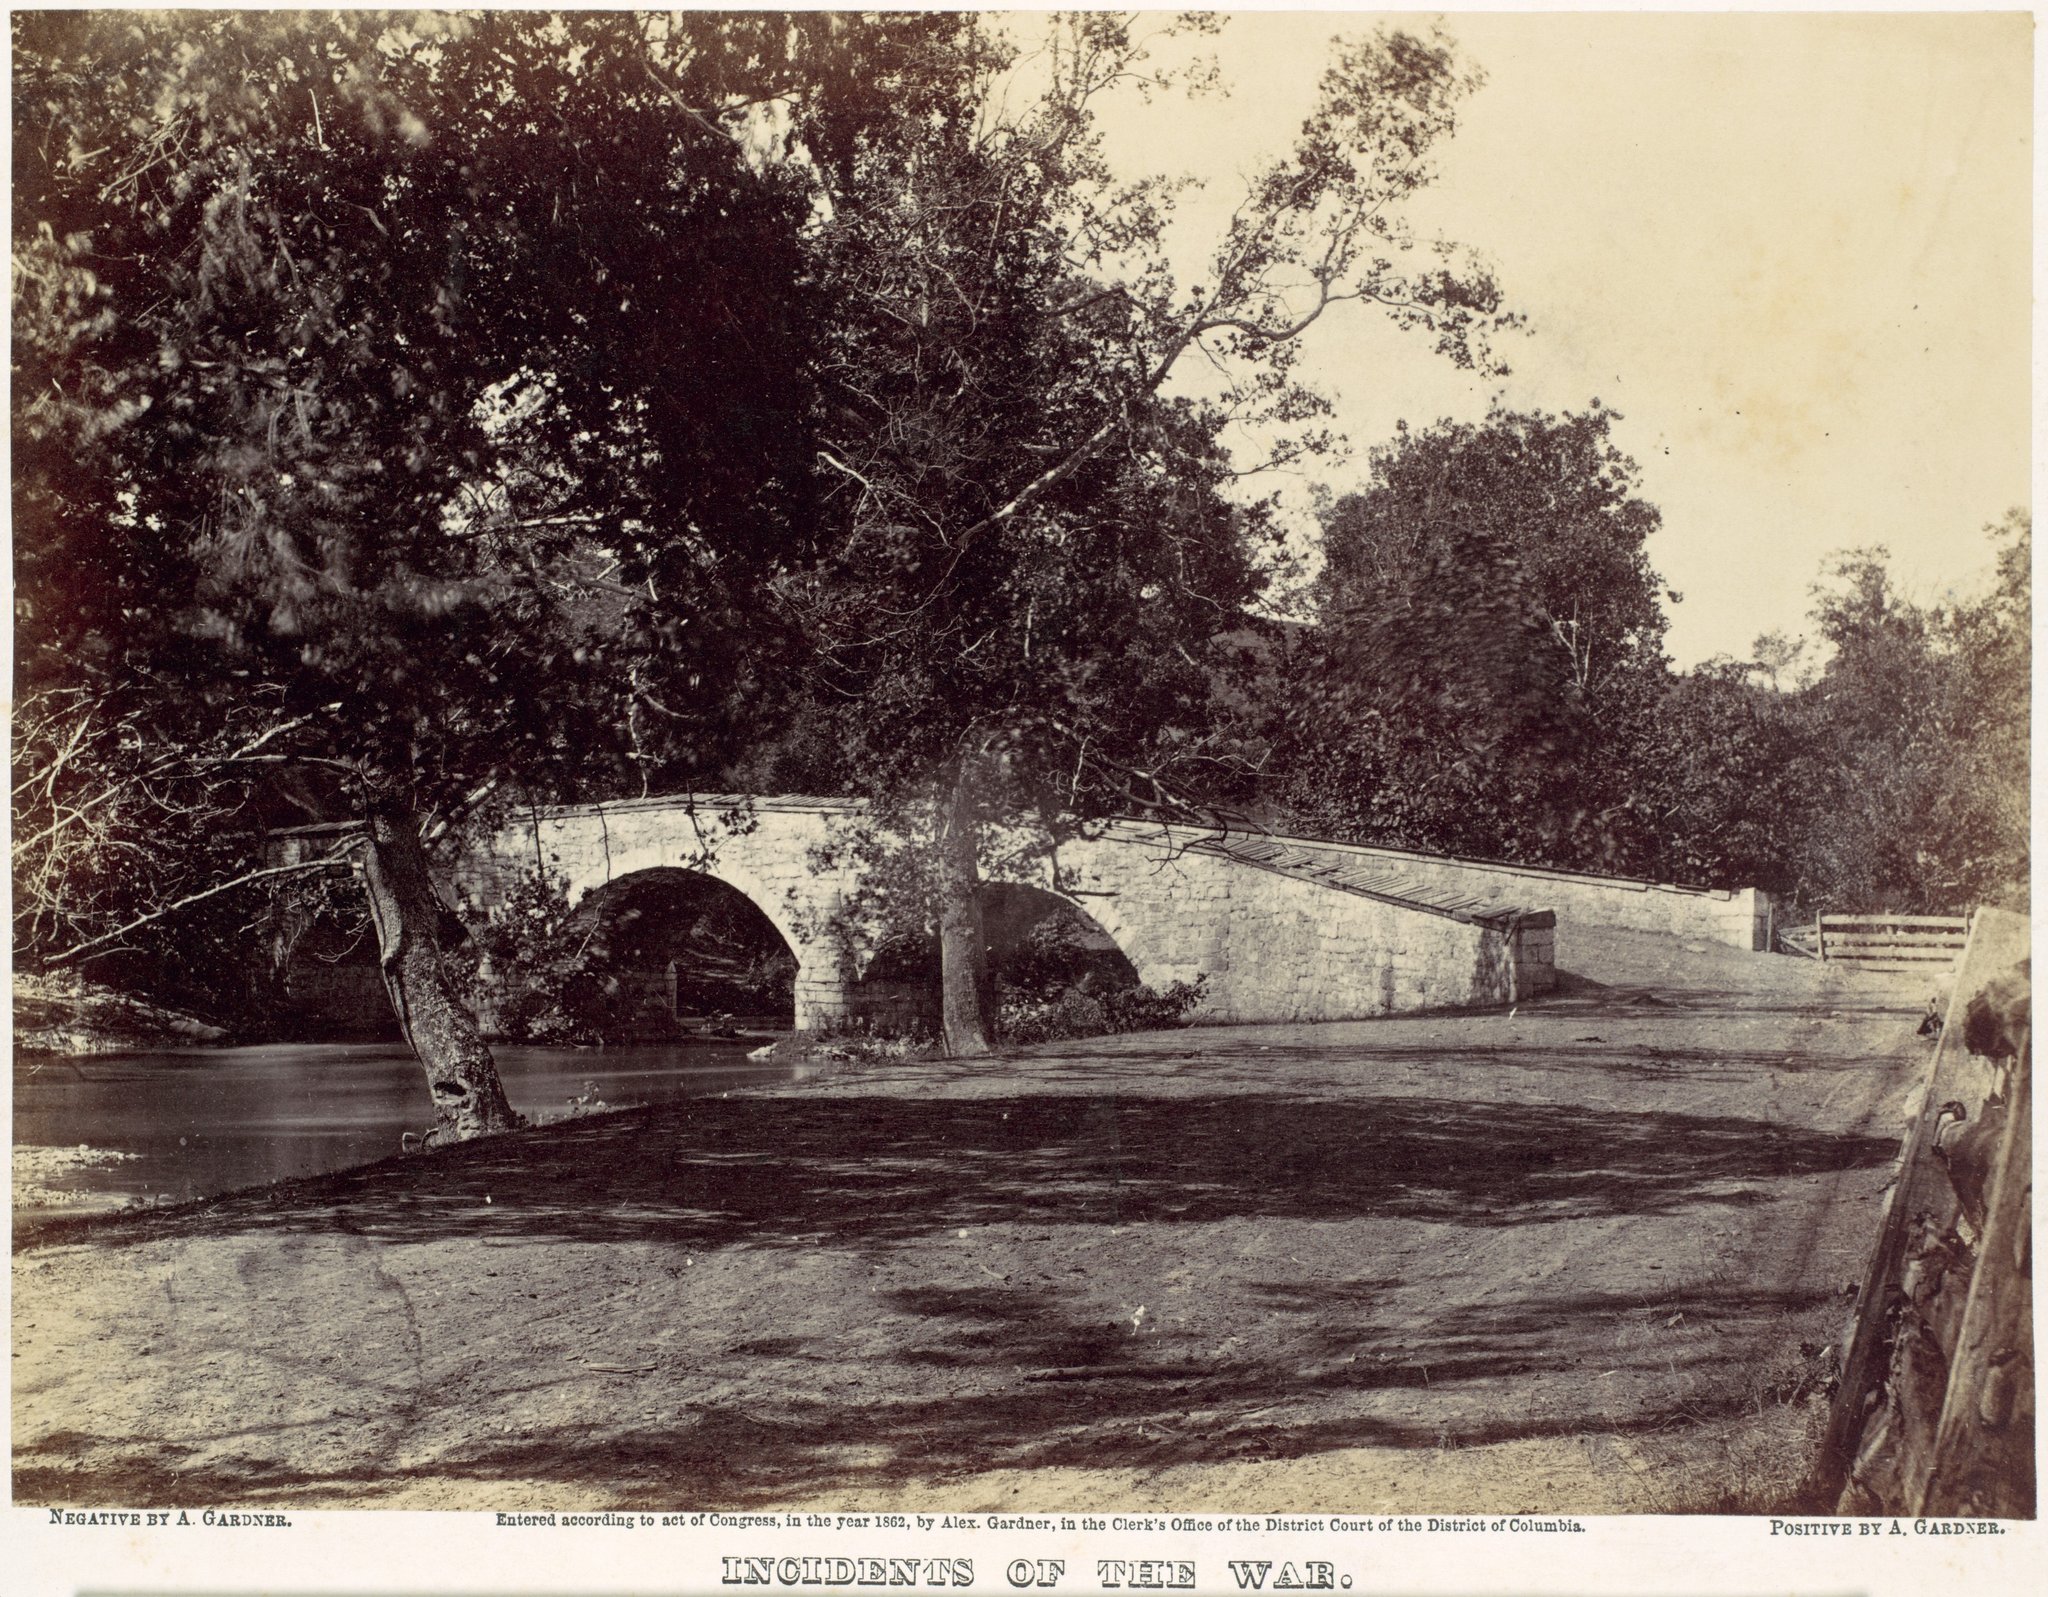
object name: photograph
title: Burnside Bridge, Across the Antietam, near Sharpsburg, No. 1, September 1862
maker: alexander gardner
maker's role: artist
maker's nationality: american, scottish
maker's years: 1821-1882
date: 1862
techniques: albumen silver print, glass negative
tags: bridges,american civil war